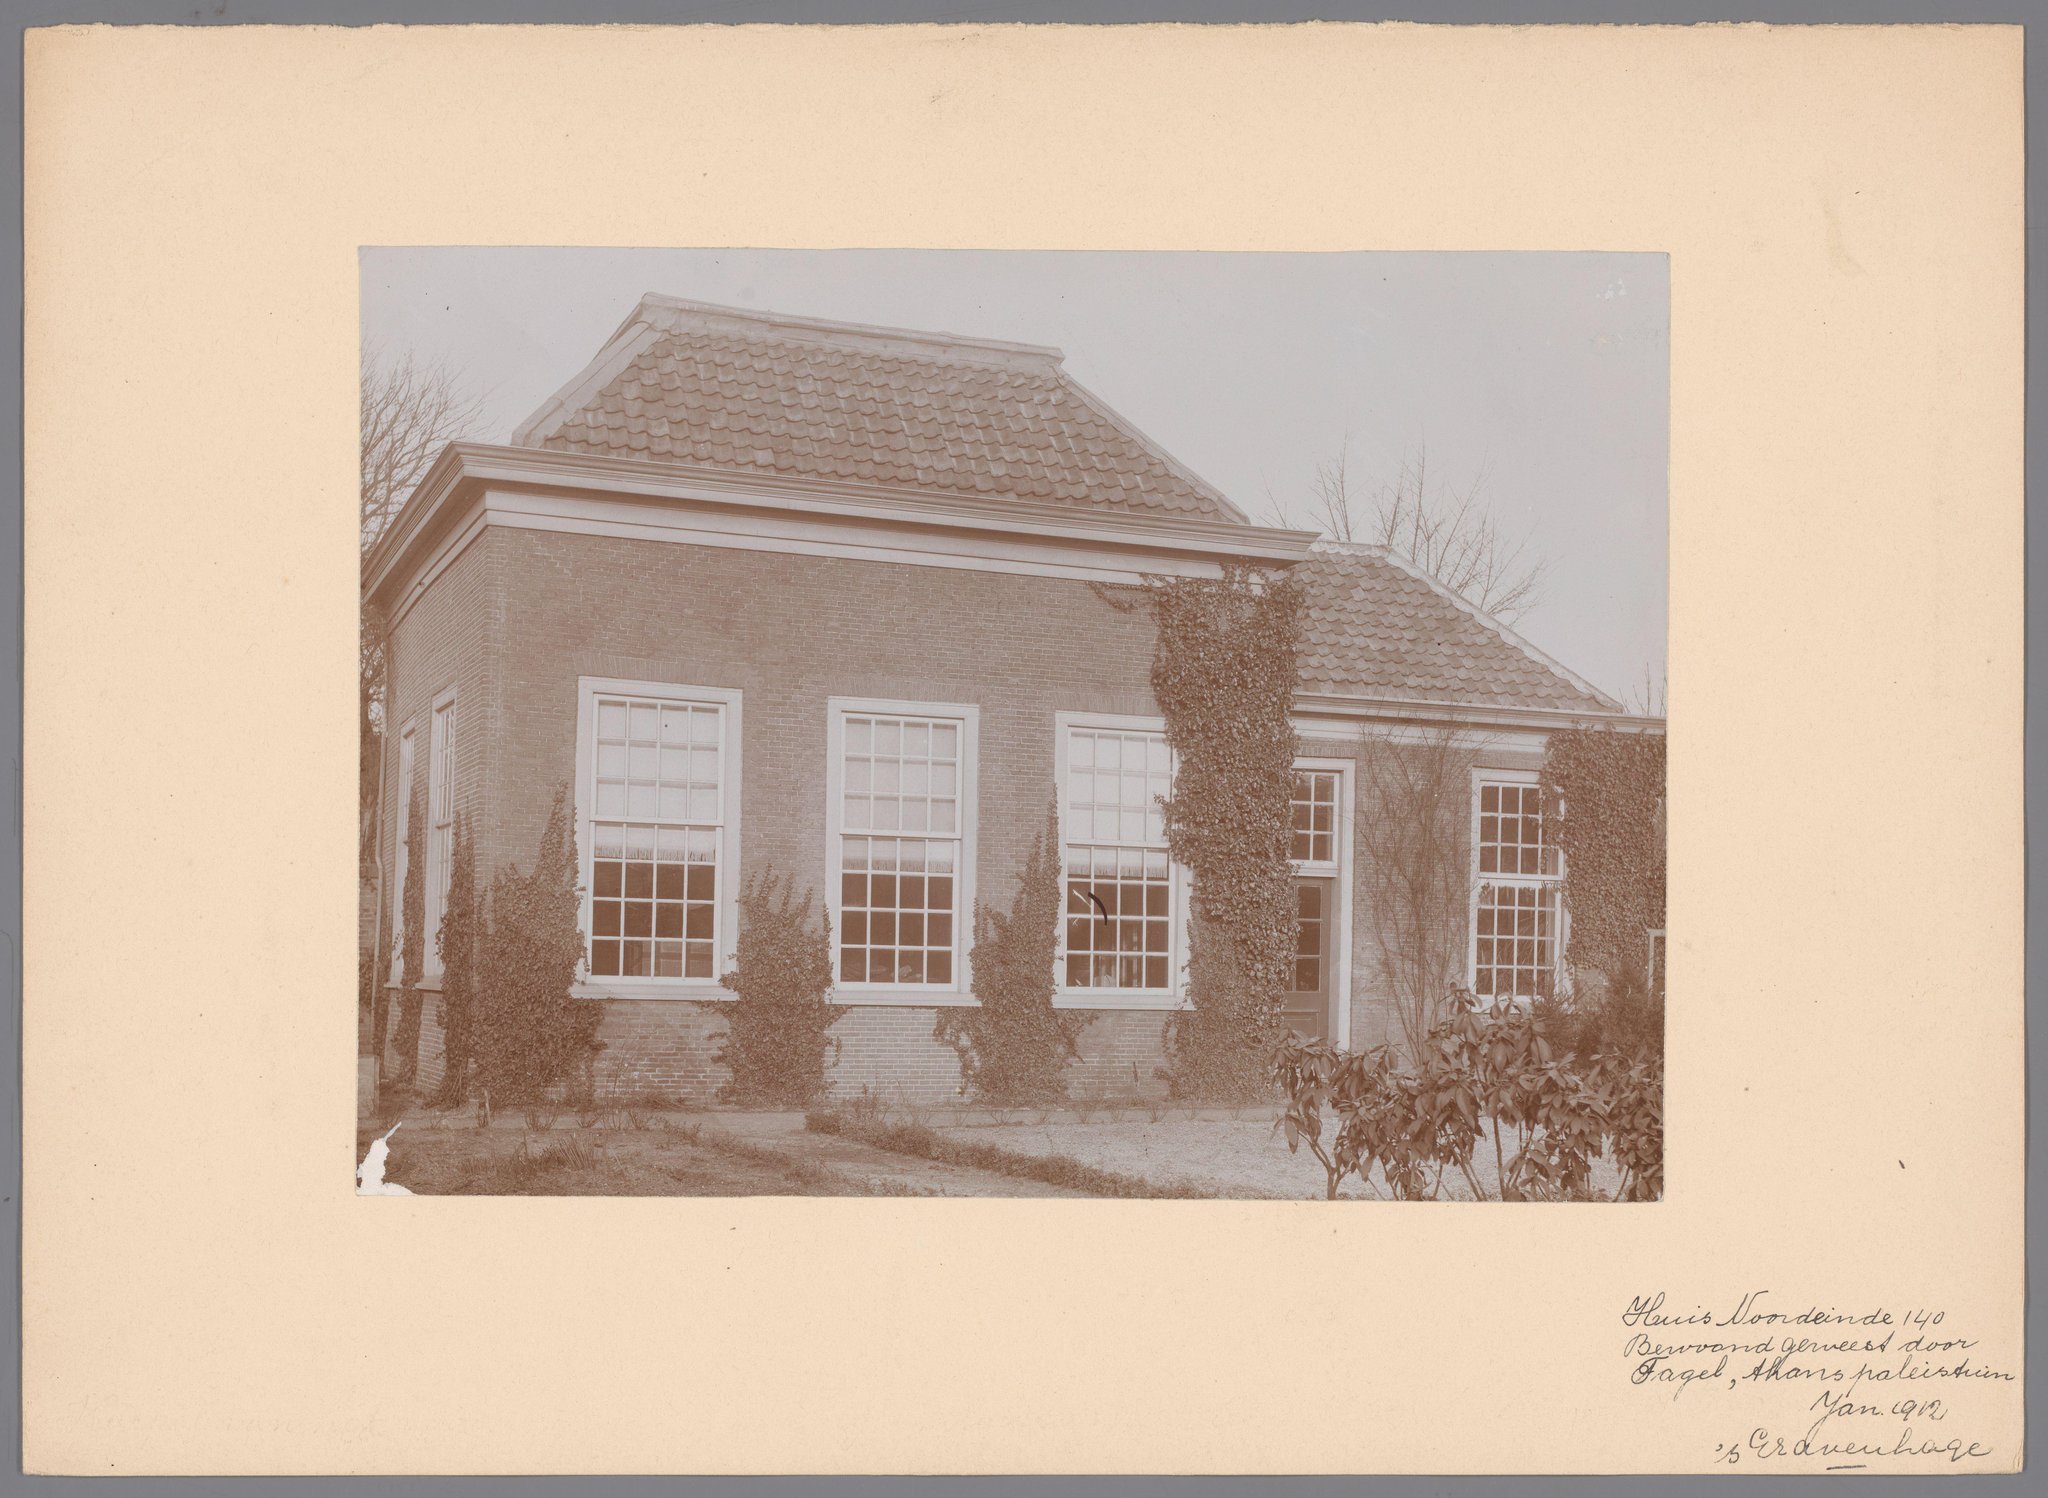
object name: photograph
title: Pand op Noordeinde 140 te Den Haag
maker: anoniem (monumentenzorg)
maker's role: fotograaf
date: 1912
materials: cardboard, photographic support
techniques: collodion silver print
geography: noordeinde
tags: urban housing, façade (of house or building)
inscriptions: annotation: ‘Huis Noordeinde 140/ Bewaard geweest door Fagel, thans paleistuin/ Jan. 1912/ 's Gravenhage’